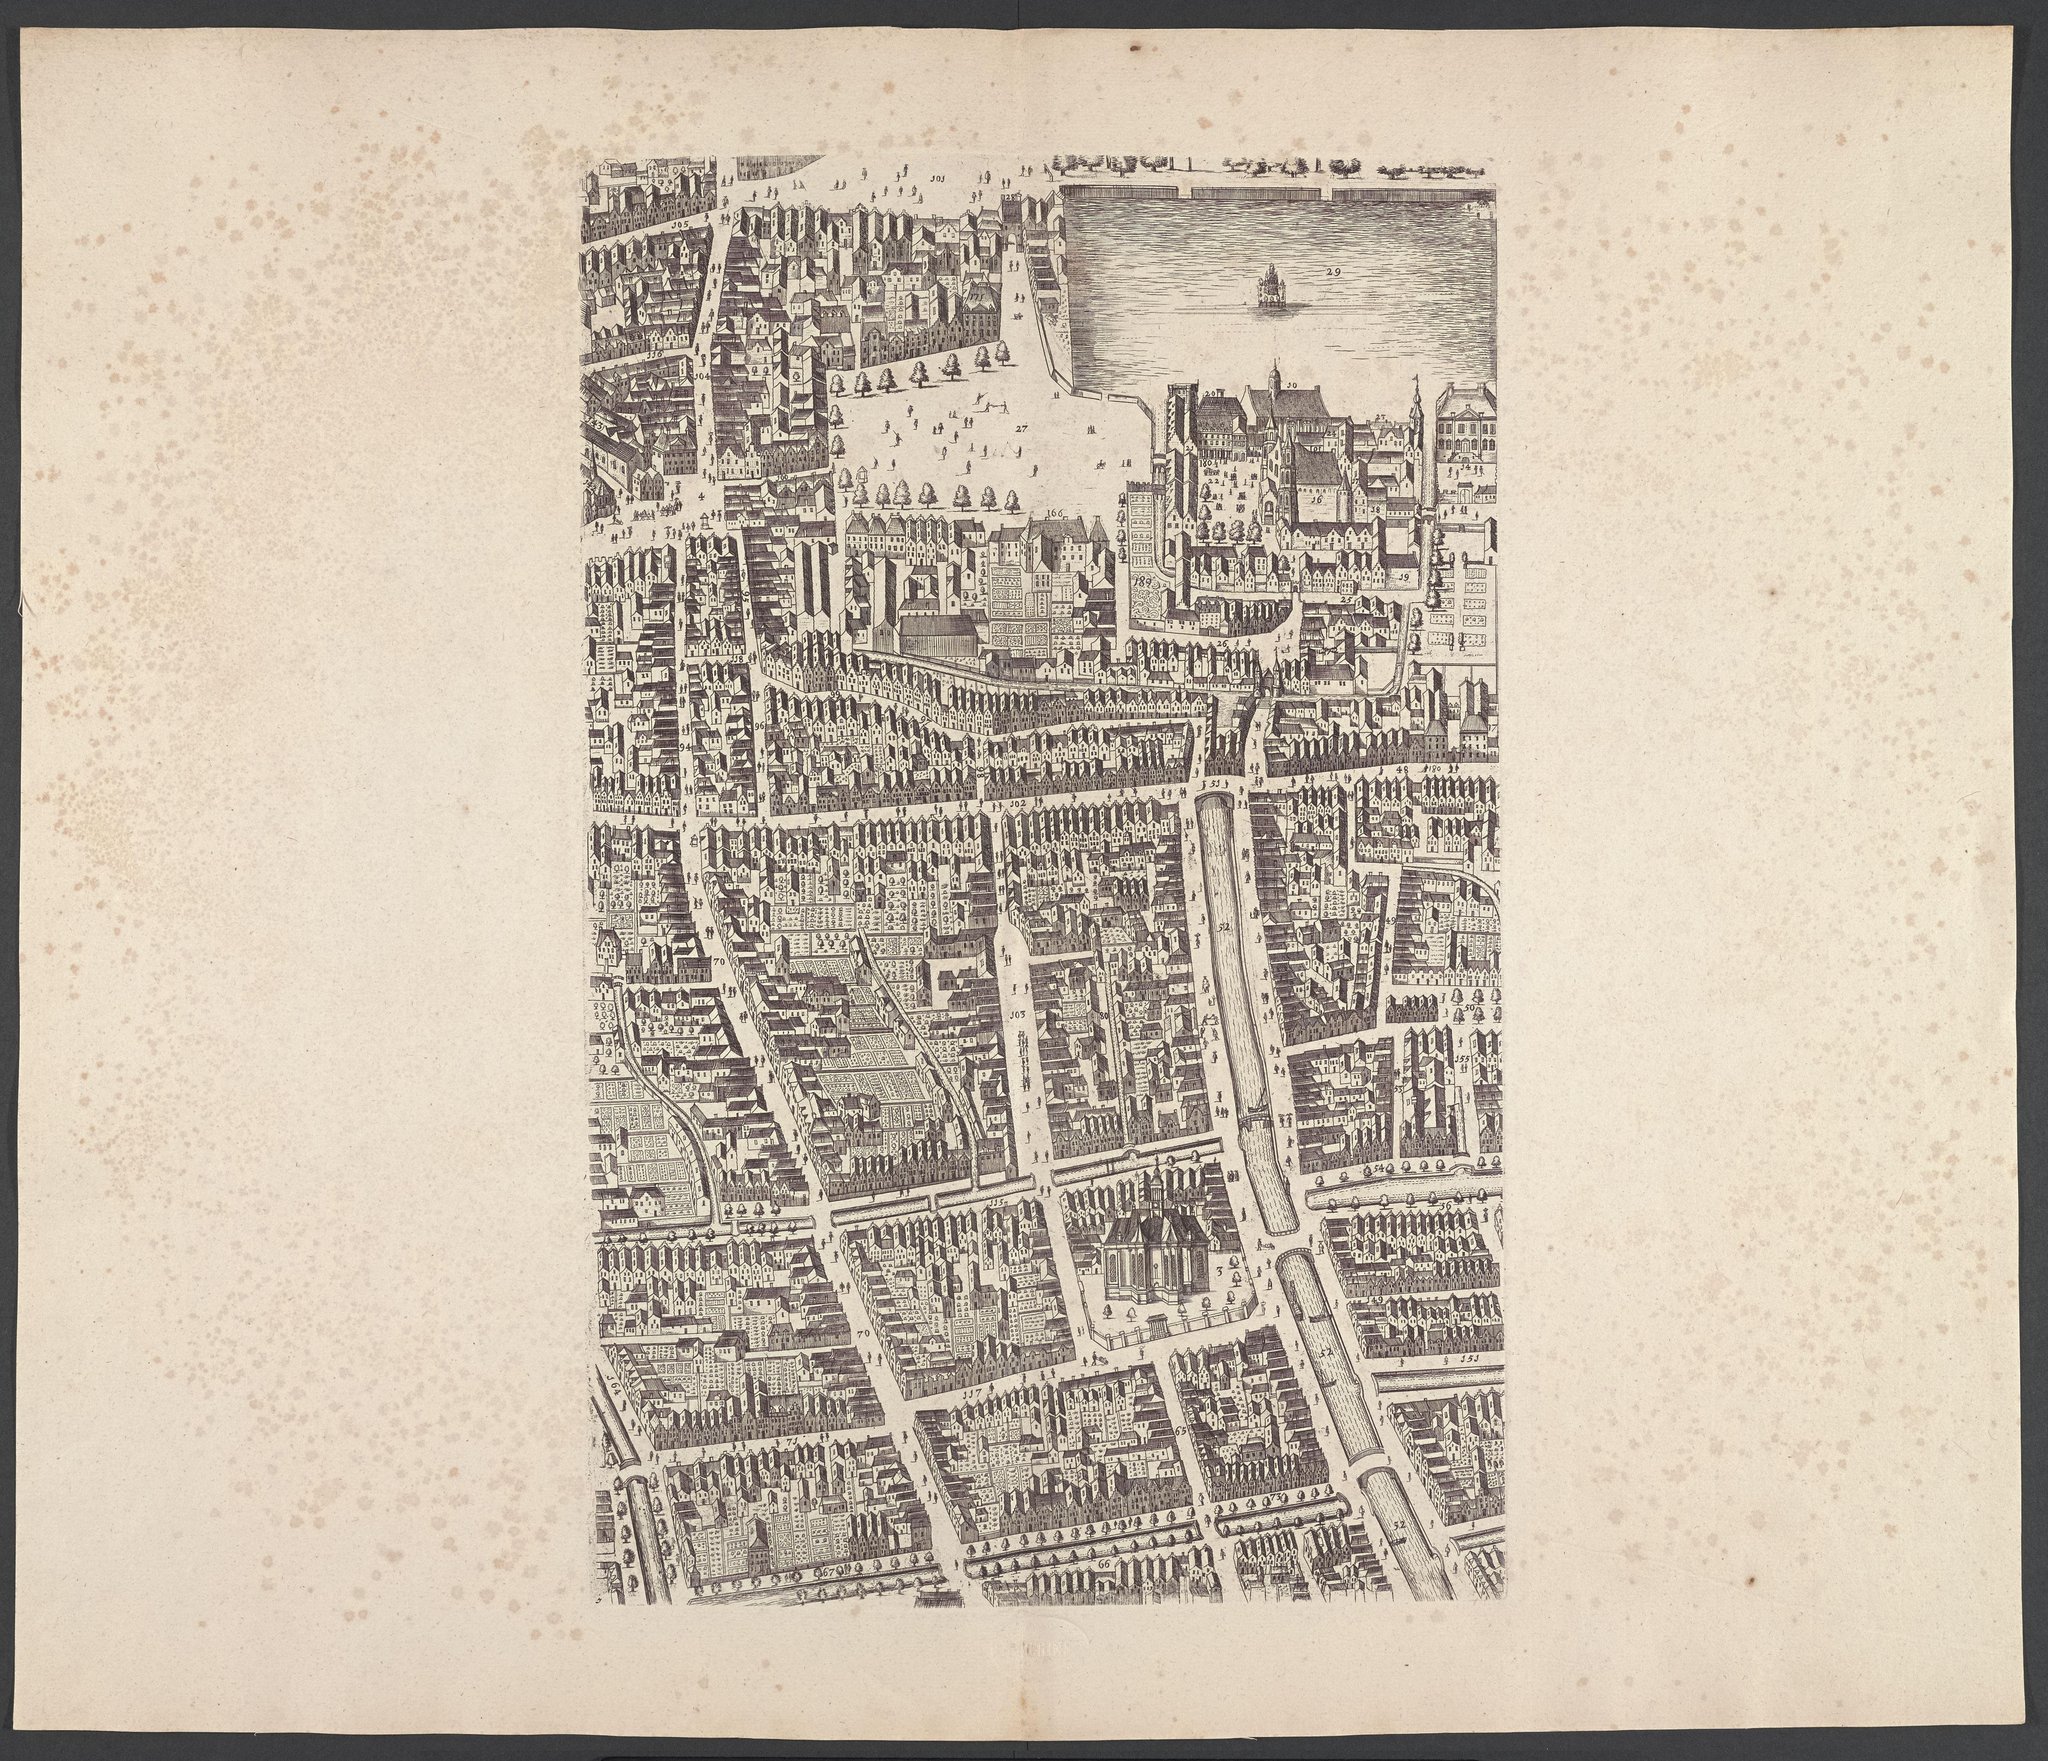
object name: print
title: Plattegrond van Den Haag (zevende deel)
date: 1665-1667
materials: paper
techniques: etching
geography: the hague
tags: maps of cities, the hague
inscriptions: collector's mark: Lugt 2228, check stamp: ‘Archief Ministerie van Oorlog Afdeeling Genie’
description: Deze prent is onderdeel van een plattegrond van Den Haag. Deze staat van de plattegrond werd oorspronkelijk uitgegeven met een sierrand, bestaande uit een gezicht op de stad en veertien kleinere gezichten in en om Den Haag, en vormde zo de zogenaamde figuratieve kaart van Den Haag. Voor de prenten die de rand vormen, zie: RP-P-AO-12-8, RP-P-AO-12-8-2, RP-P-OB-50.201, RP-P-OB-50.202, RP-P-OB-50.203, RP-P-OB-50.204, RP-P-OB-50.205, RP-P-OB-50.206, RP-P-OB-50.207, RP-P-OB-50.208, RP-P-OB-102.387, RP-P-OB-50.209, RP-P-OB-50.210, RP-P-OB-50.211, RP-P-OB-50.212, RP-P-OB-50.213, RP-P-AO-12-5-4 en RP-P-OB-50.214.